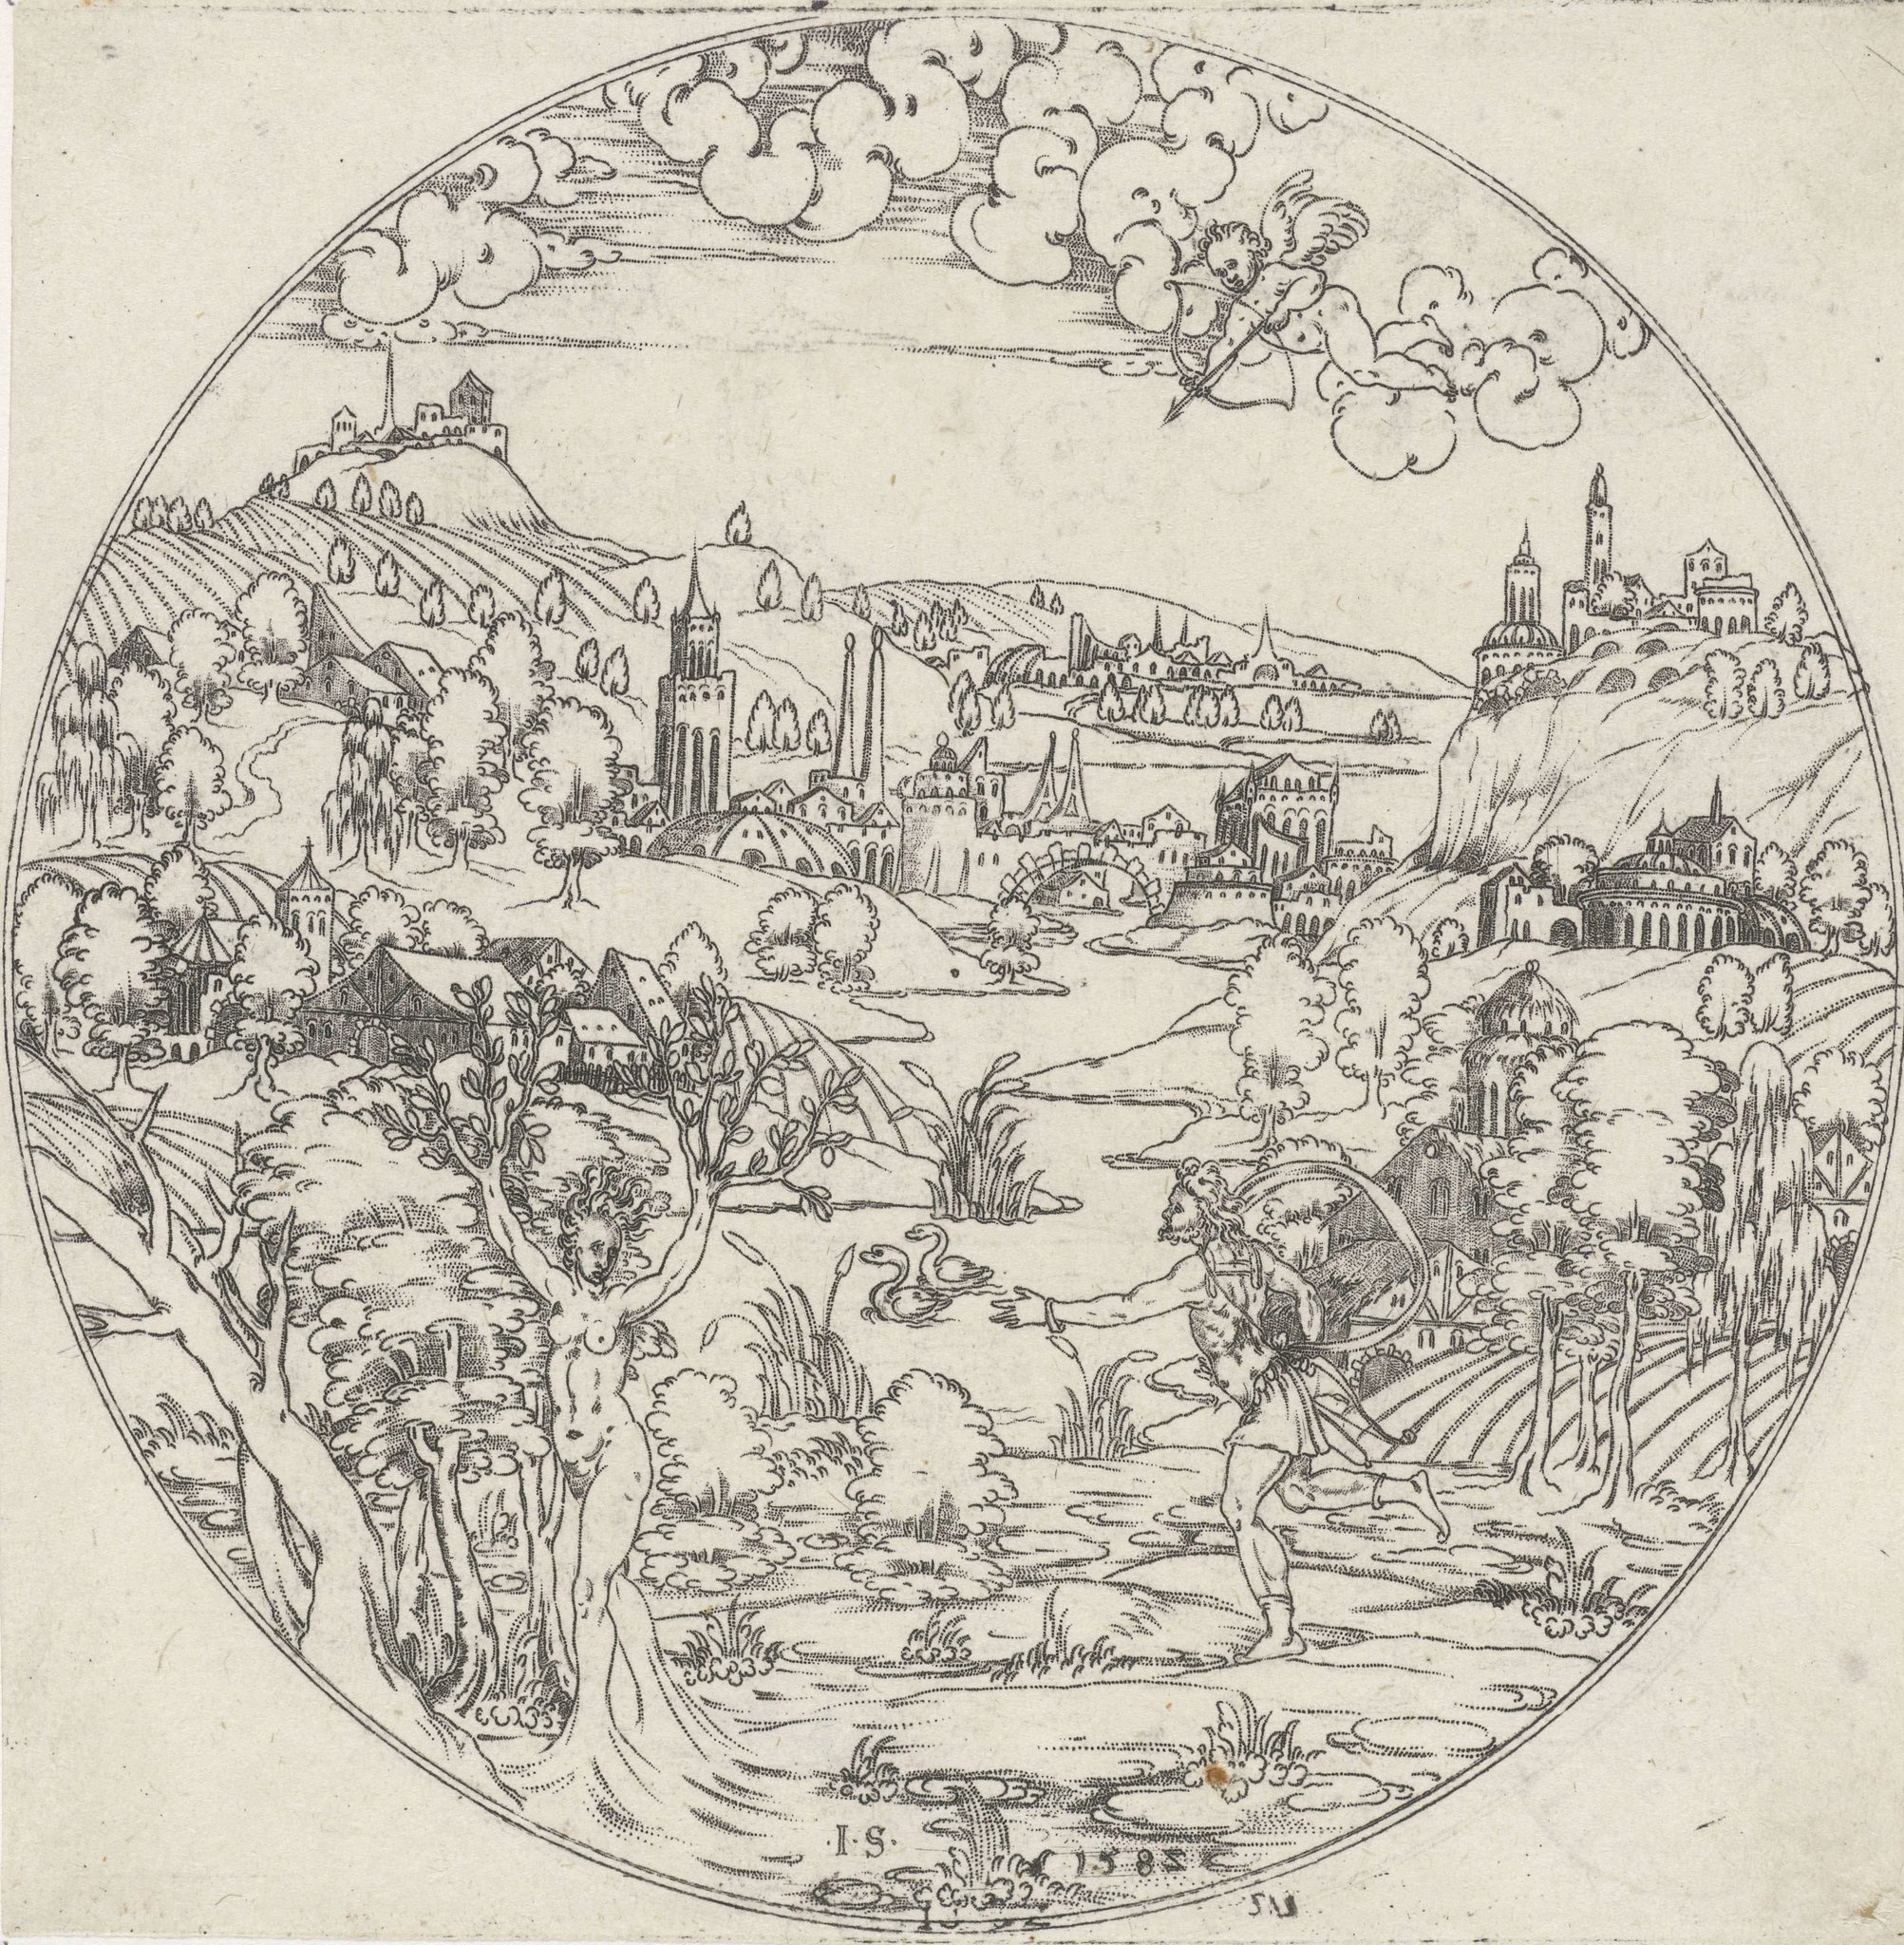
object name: ornament print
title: Bodems van schalen: landschappen met bijbelse en mythologische voorstellingen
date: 1572-1582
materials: paper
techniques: engraving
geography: germany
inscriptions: collector's mark: Lugt 240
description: In de lucht zweeft een putto met pijl en boog. Uit serie van 8 bladen?